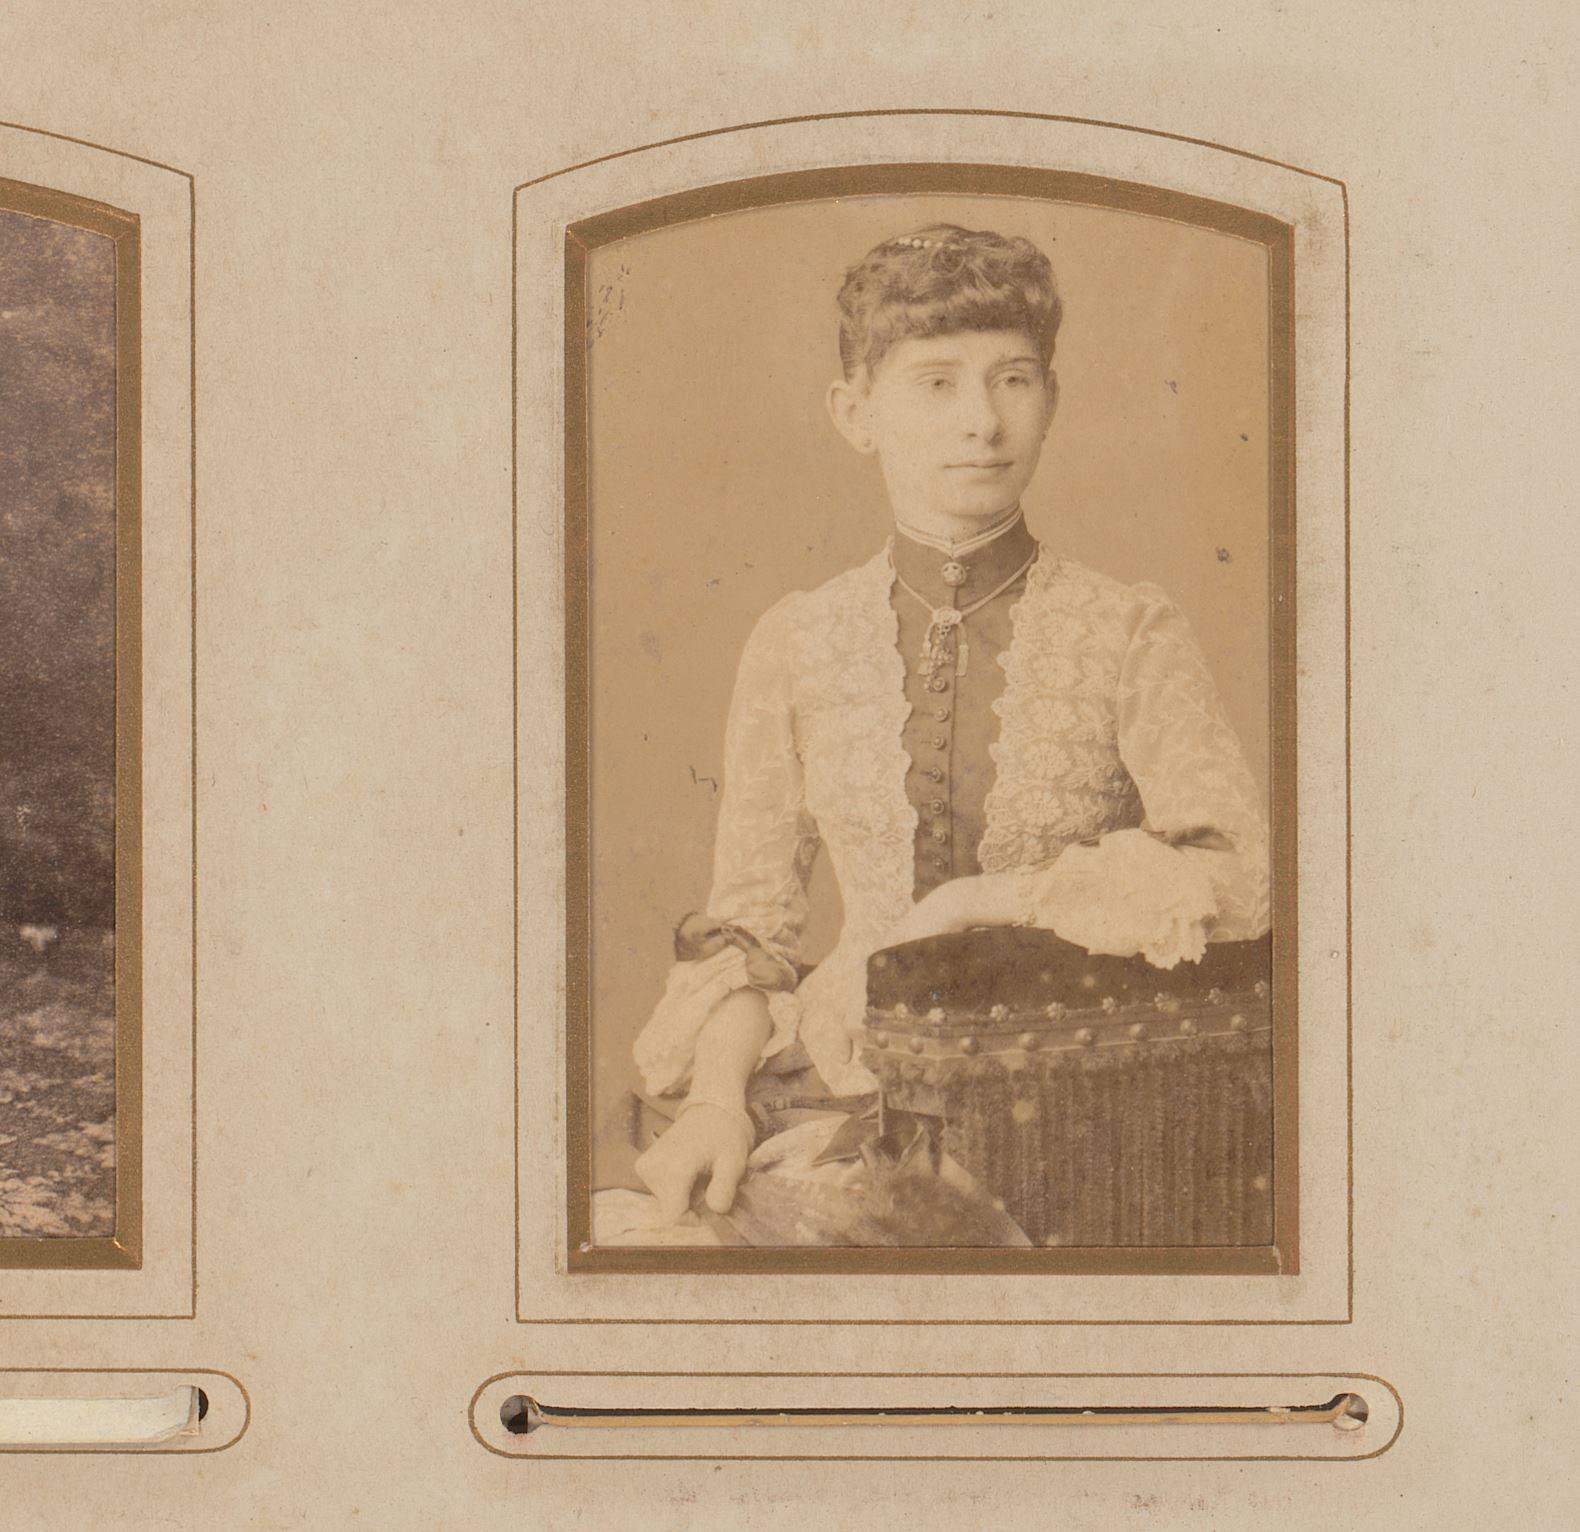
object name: photograph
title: Portret van een zittende vrouw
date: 1884-1887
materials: cardboard, photographic support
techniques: albumen print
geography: surabaya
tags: sitting figure - aa - female human figure, historical persons - bb - woman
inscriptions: inscription: ‘Photographie Instantanée/ Charls & van Es/ Soerabaia./ Specialiteit in Vergrootingen.’